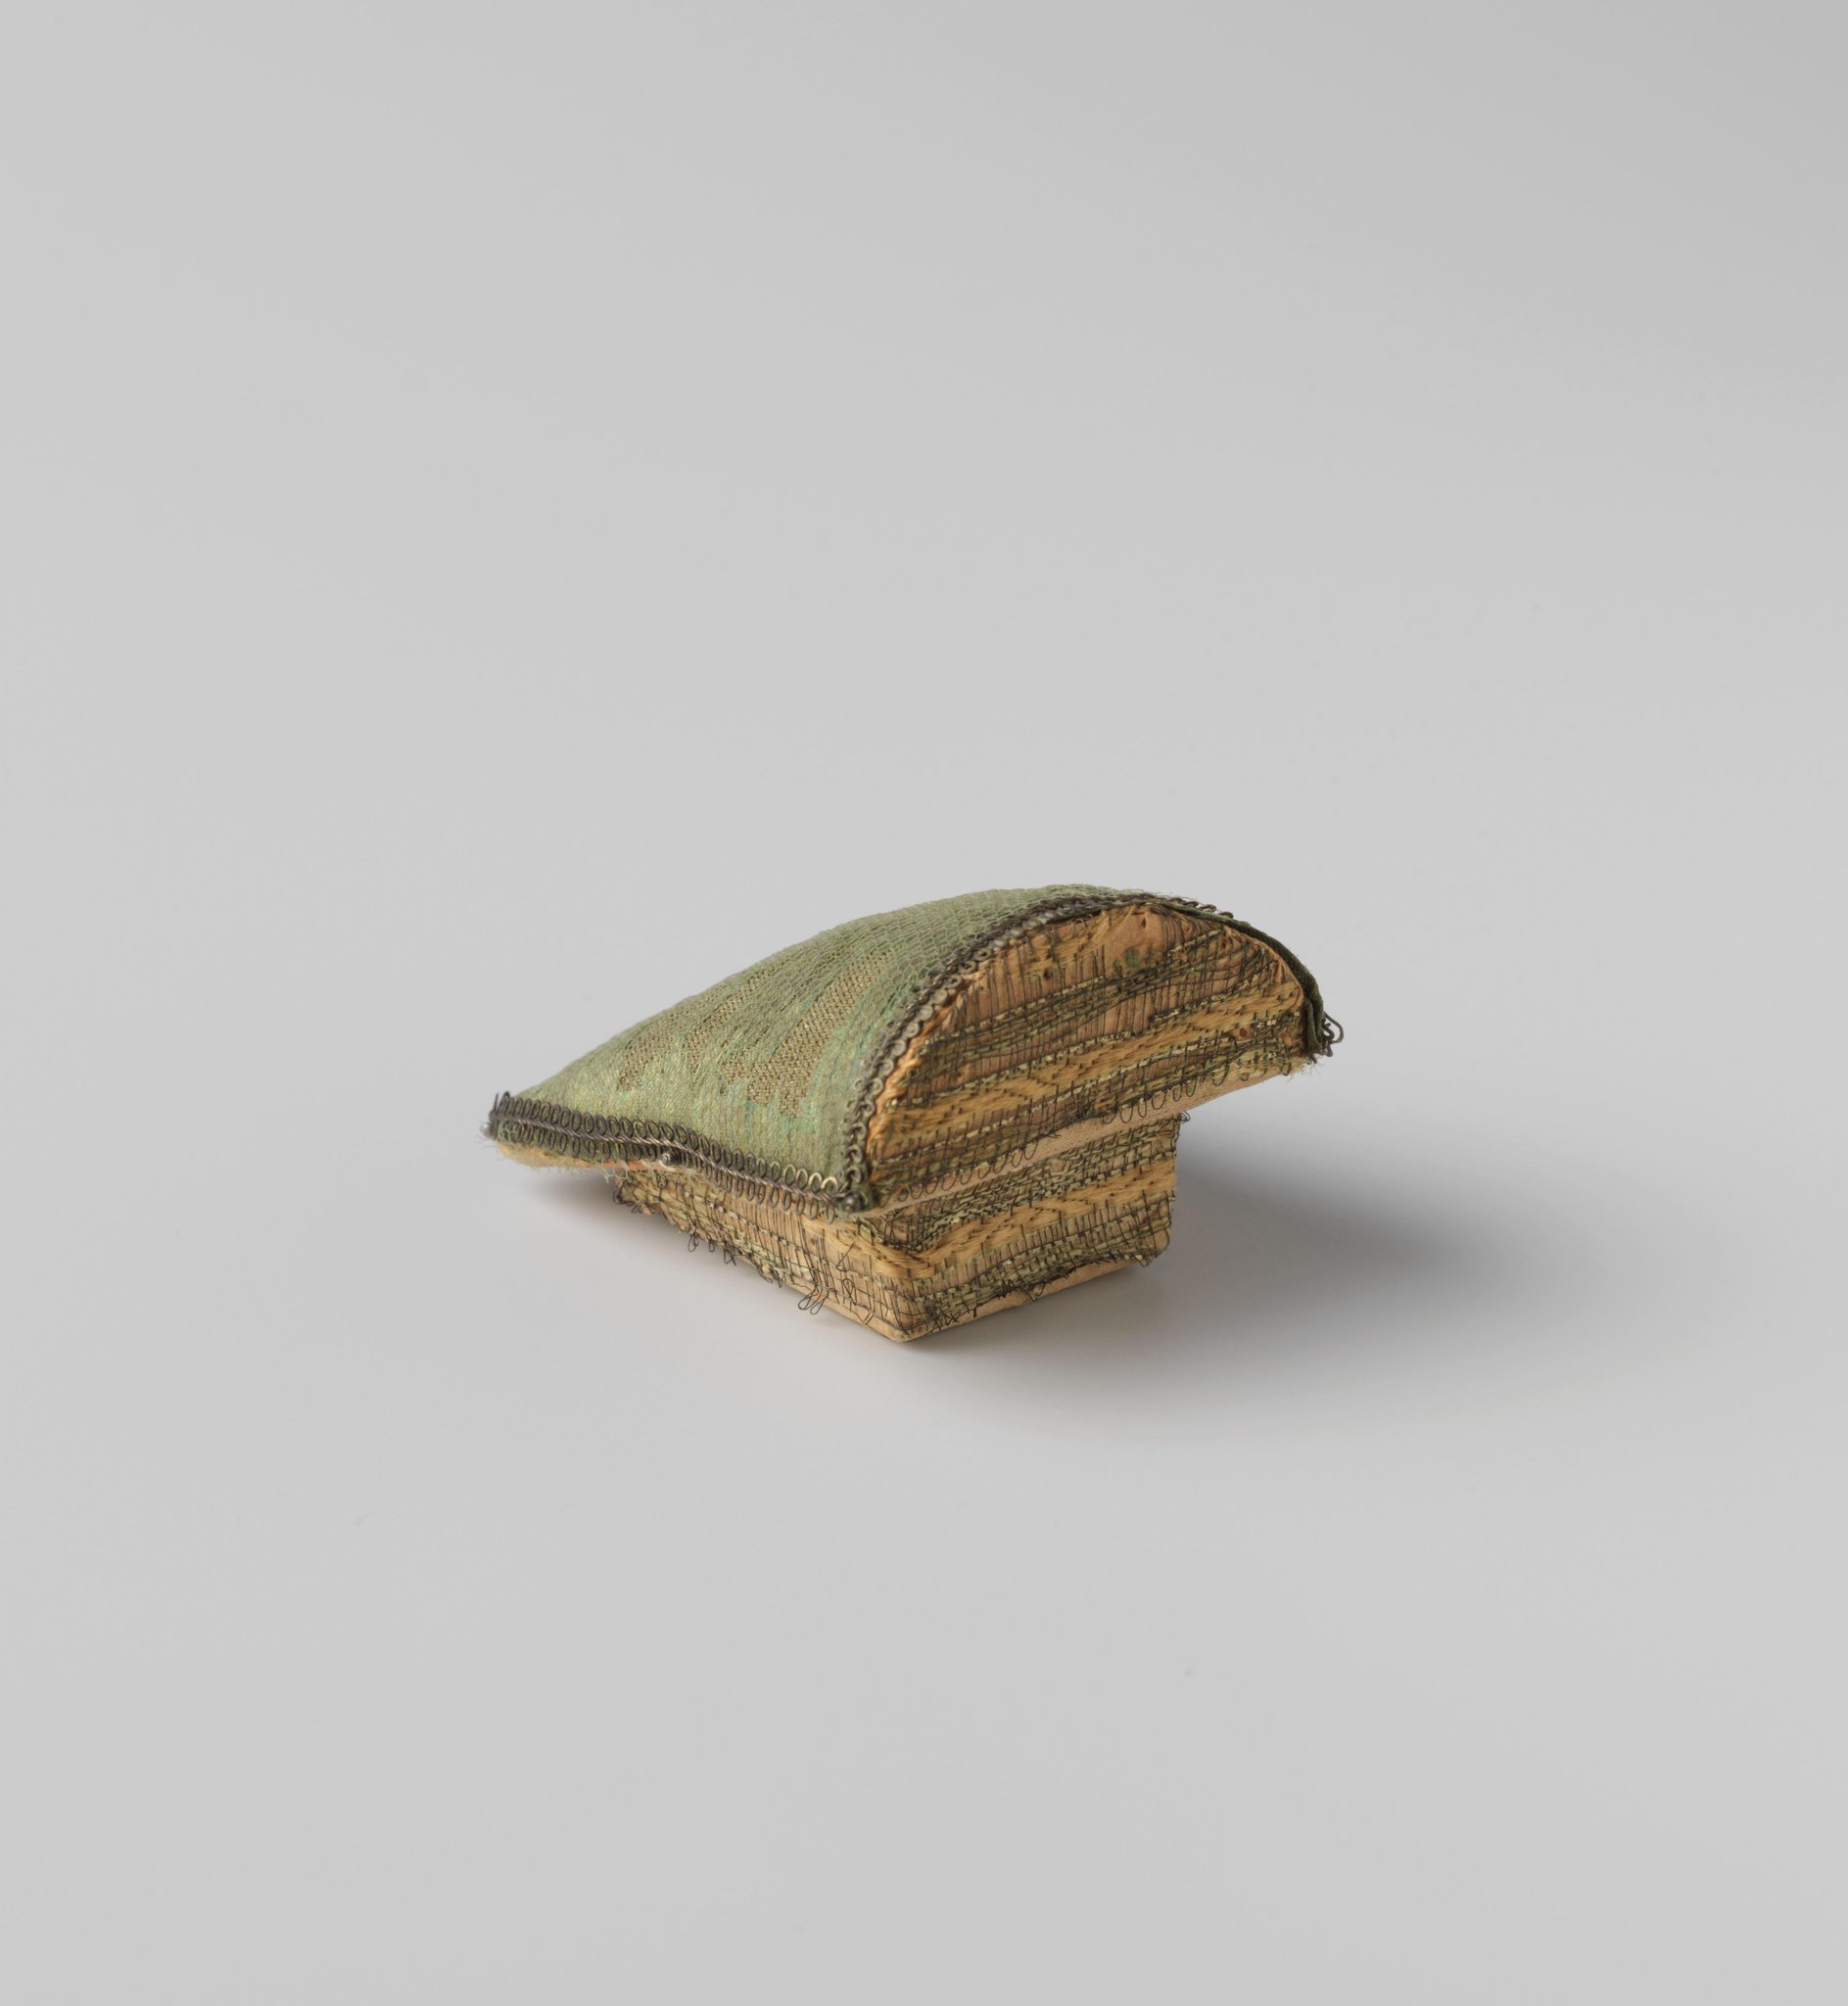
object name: kantkloskussen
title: Kantkloskussen, overtrokken met witte en blauw-groene zijde, afgezet met goud- en zilverdraad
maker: Anonymous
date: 1750-1800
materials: metal thread, board, silk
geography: amsterdam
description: Kantkloskussen vervaardigd van karton. De zachte vulling is overtrokken met linnen en daaroverheen met blauw-groene zijde, afgezet met metaalgalon, dat is vastgezet met spelden. De achter- en zijkanten van het kussen zijn overtrokken met zijde met goud- en zilverdraad. De onderzijde van het kussen is van witte zijde.